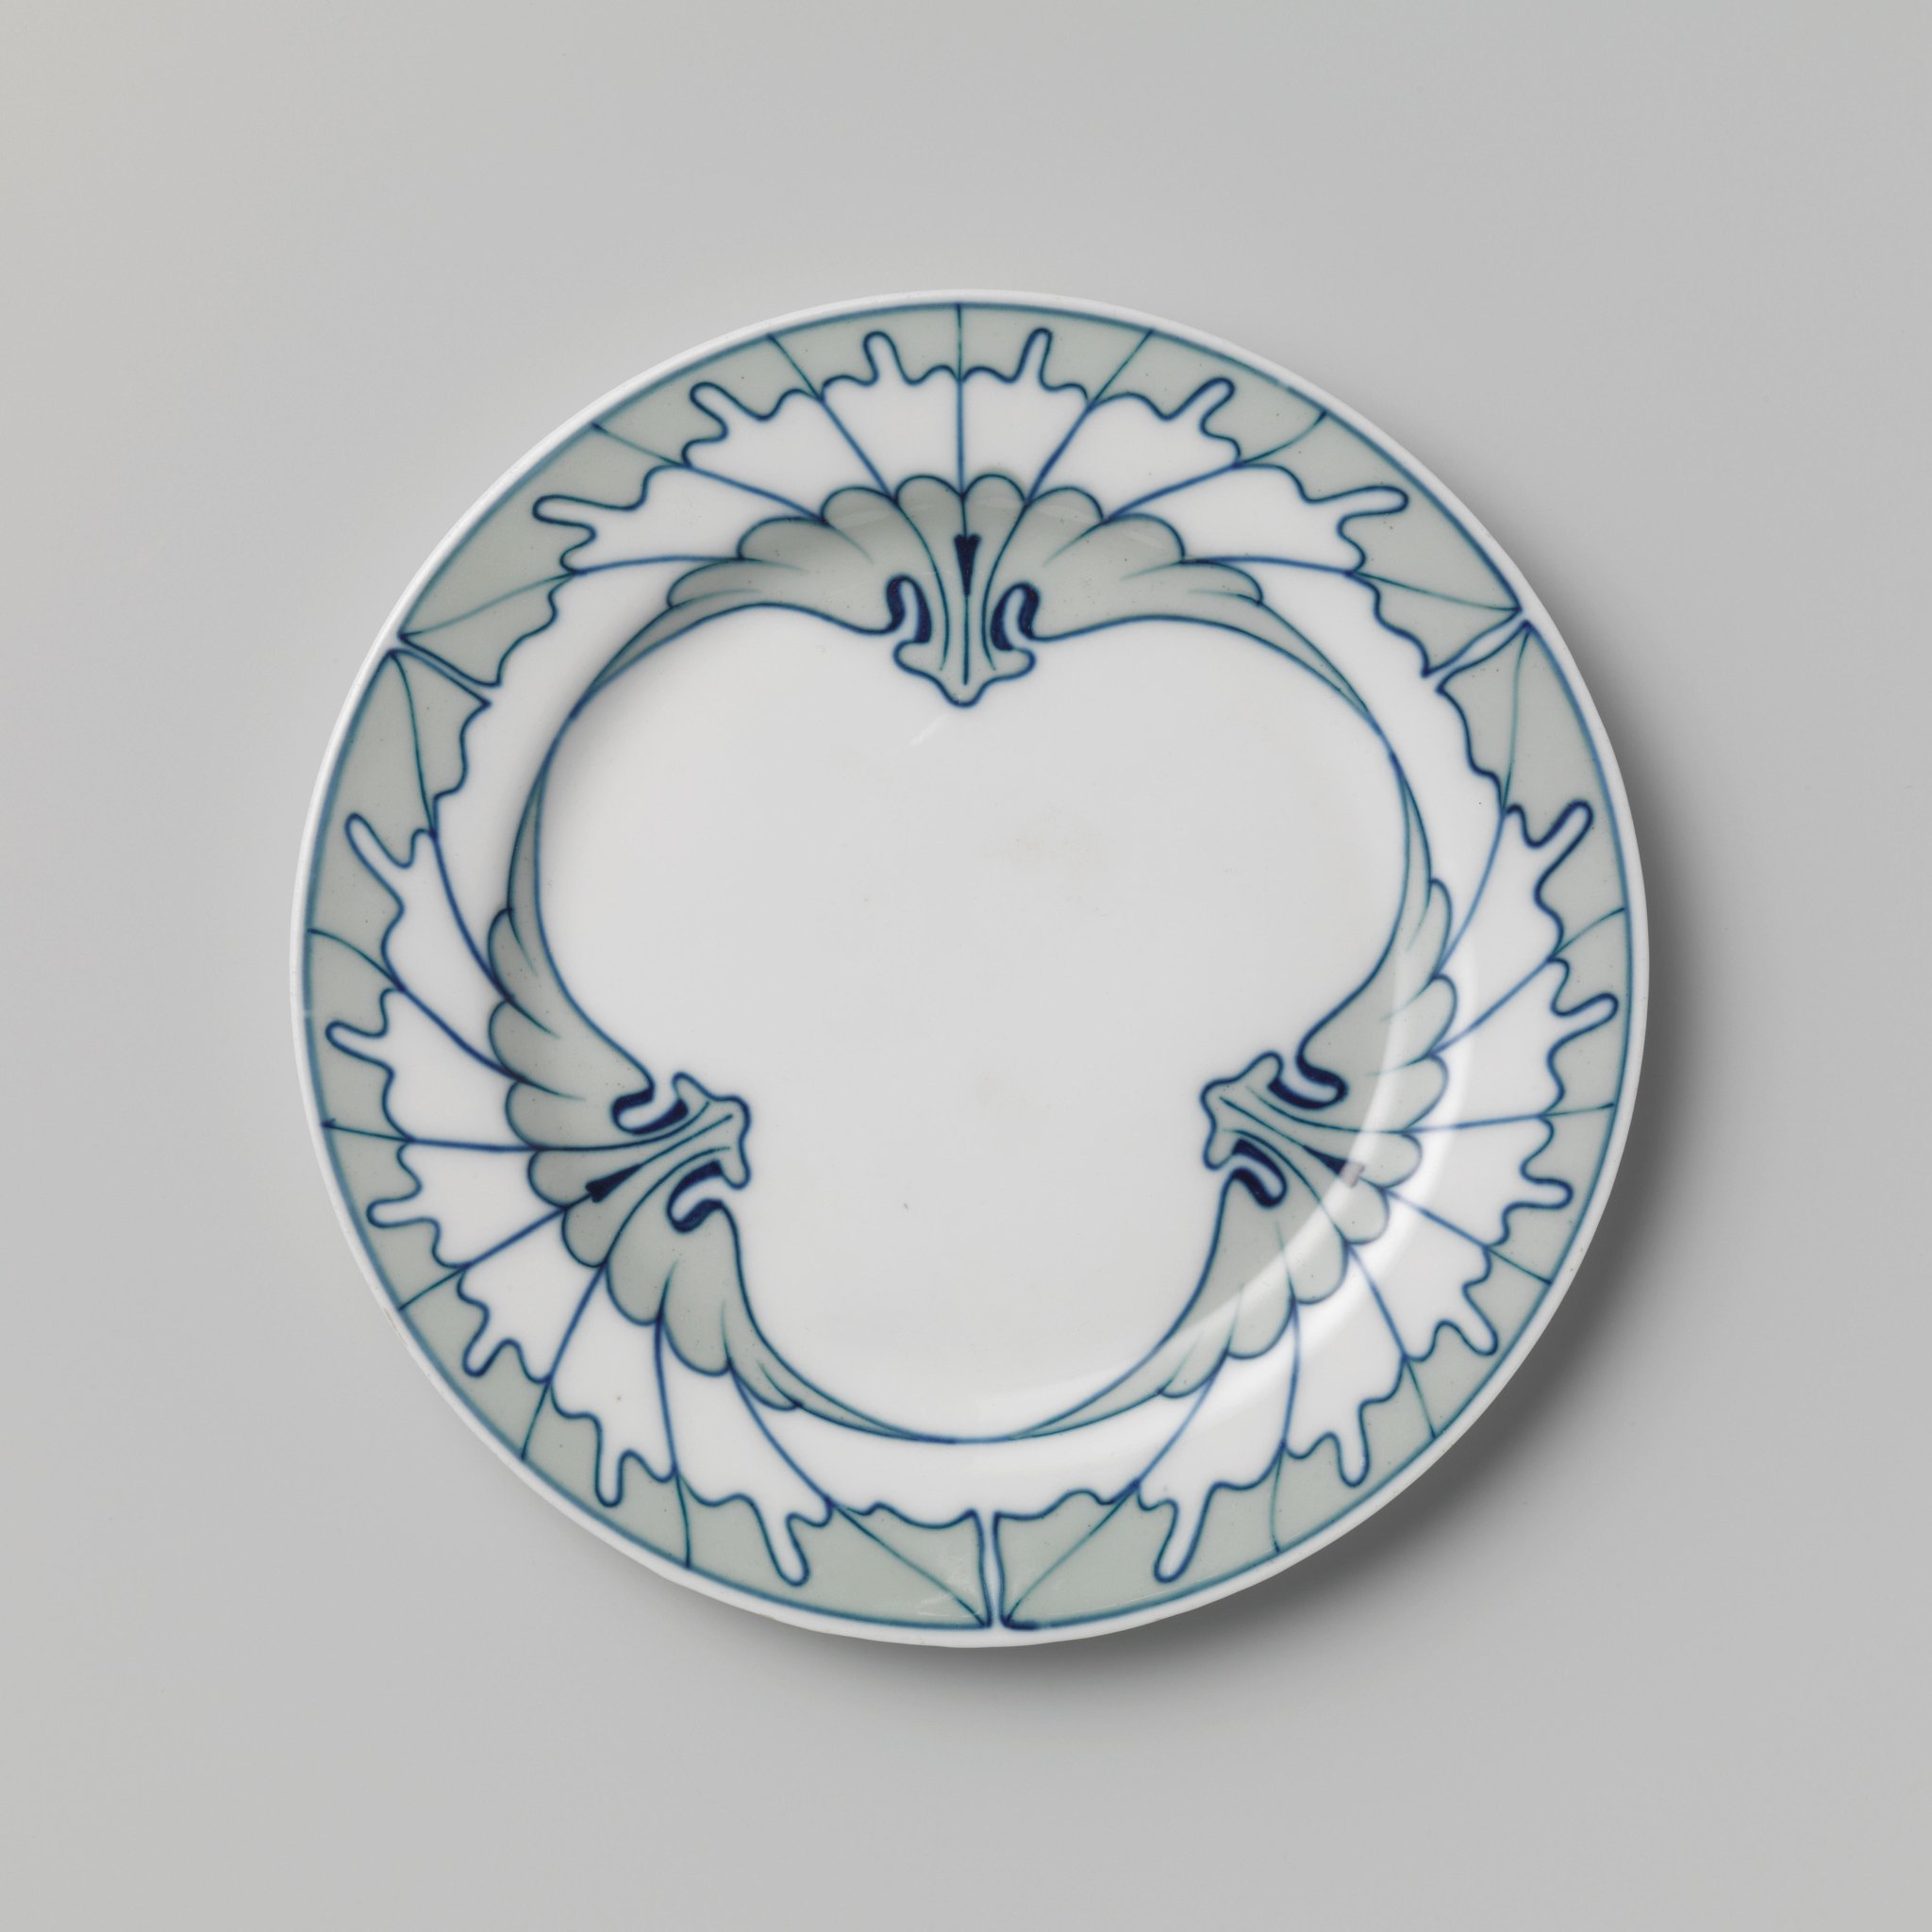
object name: eating drinking utensil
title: Bord, beschilderd met het Flügelmuster-decor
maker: konrad hentschel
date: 1901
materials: porcelain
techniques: painted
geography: meissen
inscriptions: factory mark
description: Bord van beschilderd porselein. Het bord is beschilderd in groen en blauw met het Flügelmuster. Het bord hoort bij een servies (BK-1976-65-1 t/m BK-1976-65-34) en is gemerkt.